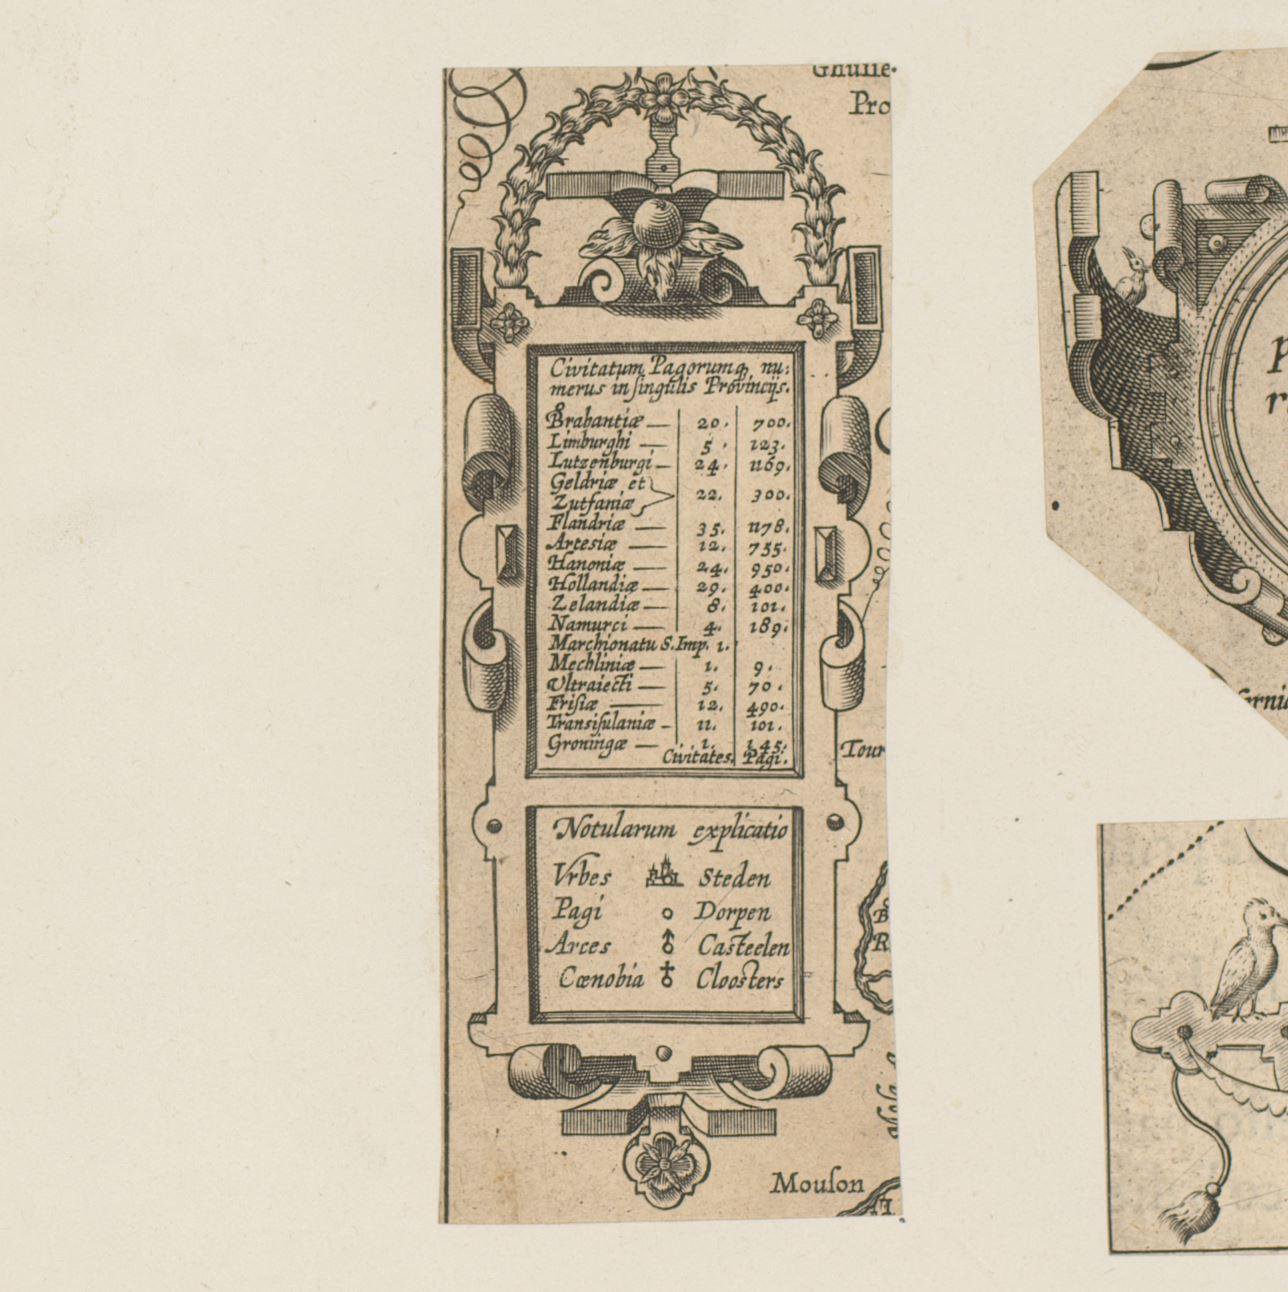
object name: print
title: Cartouche van een kaart van de Zeventien Provinciën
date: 1606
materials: paper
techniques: engraving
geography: antwerp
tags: scrollwork, strapwork ~ ornament, ornament ~ cartouche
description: Langwerpige staande cartouche met rolwerk. In de cartouche een legenda. De cartouche is een fragment van een kaart met de Zeventien Provinciën. De prent maakt deel uit van een album.